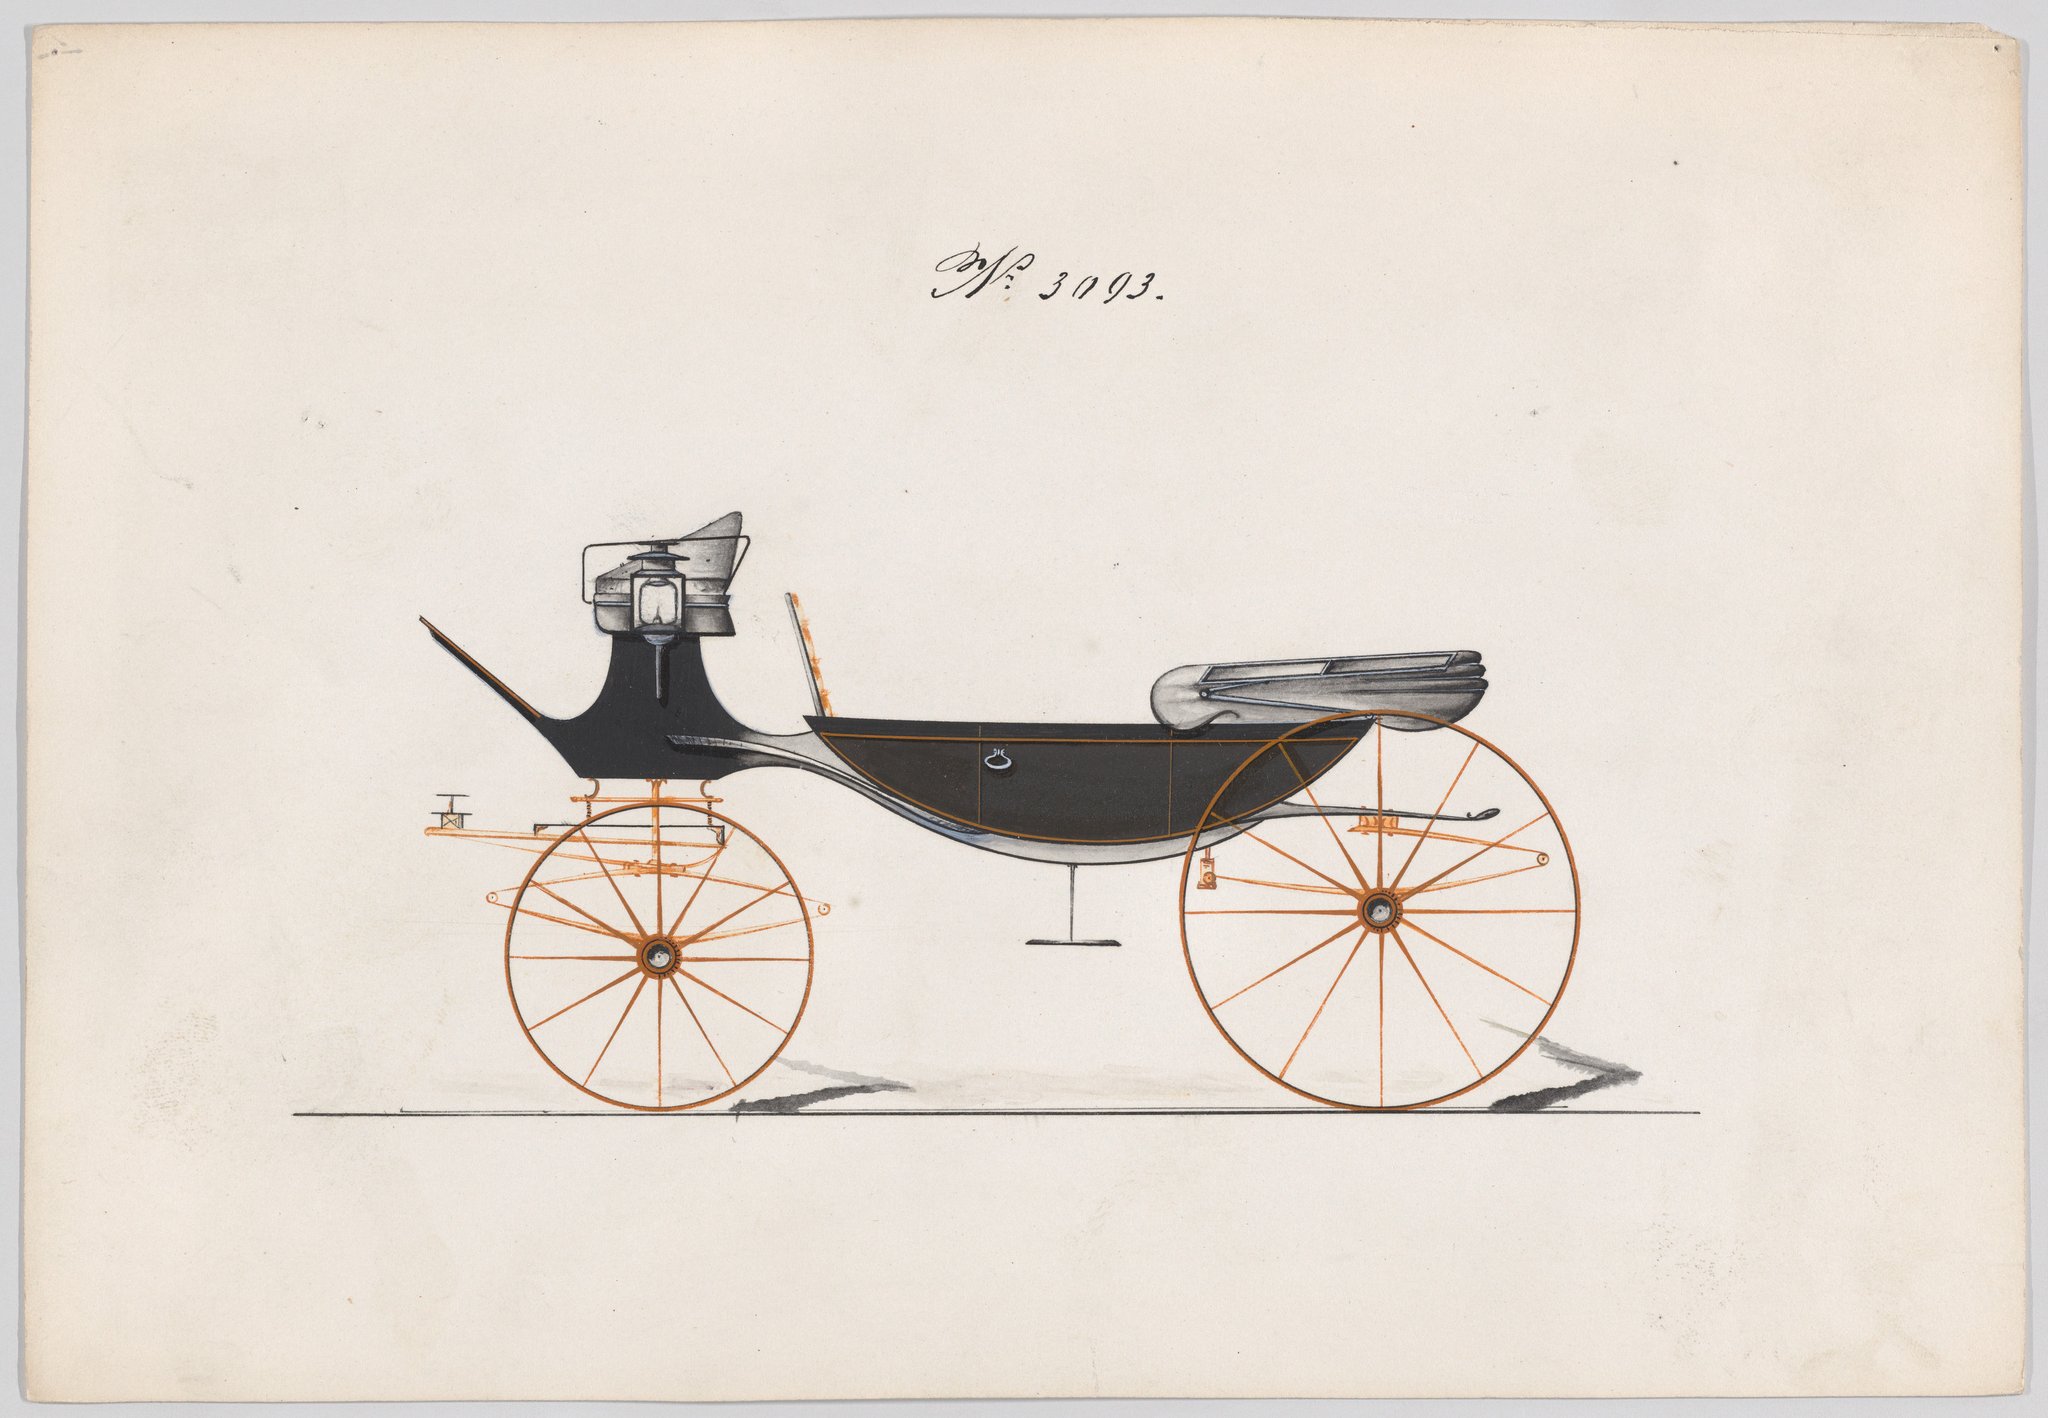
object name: drawing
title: Vis-à-vis/Brett #3093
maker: brewster & co.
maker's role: manufacturer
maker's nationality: american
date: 1875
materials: gouache, gum arabic, ink, watercolor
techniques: pen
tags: carriages